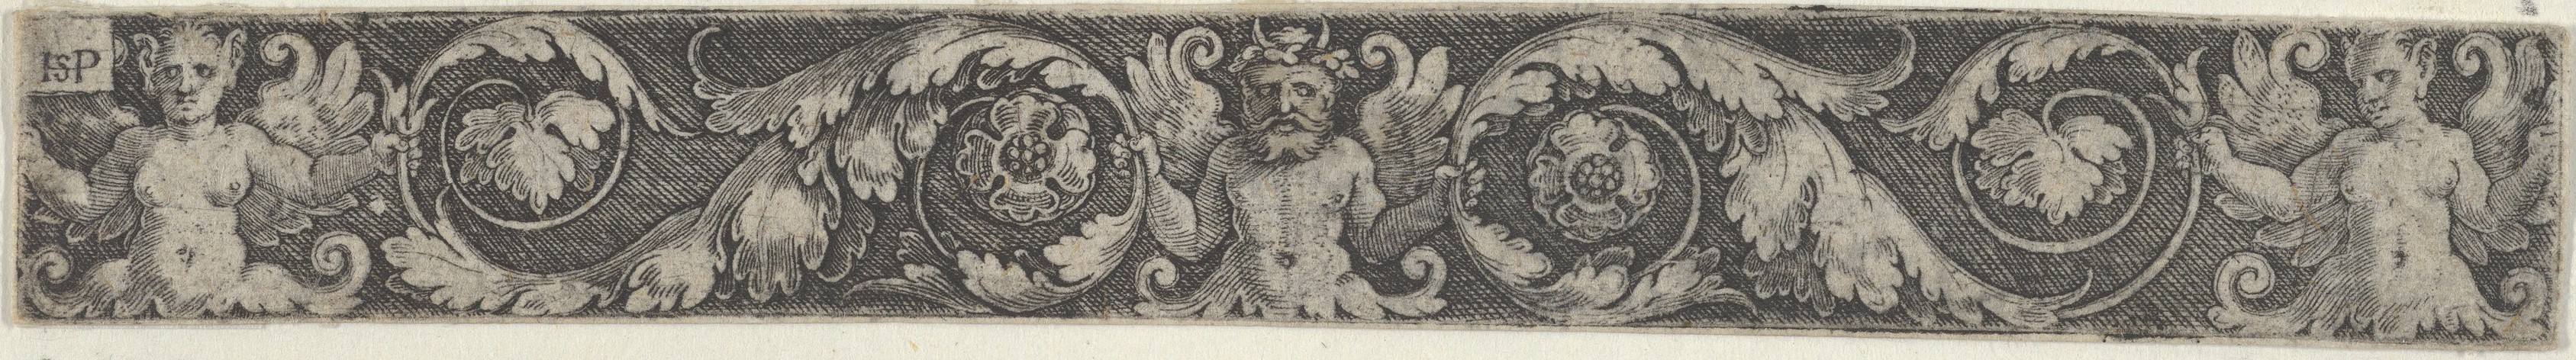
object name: print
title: Frieze with a Horned Male Figure at Center with Two Tendrils Held at Either End by Winged Female Figures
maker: sebald beham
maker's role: artist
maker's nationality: german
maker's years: 1500-1550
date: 1500-1550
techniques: engraving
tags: ornament